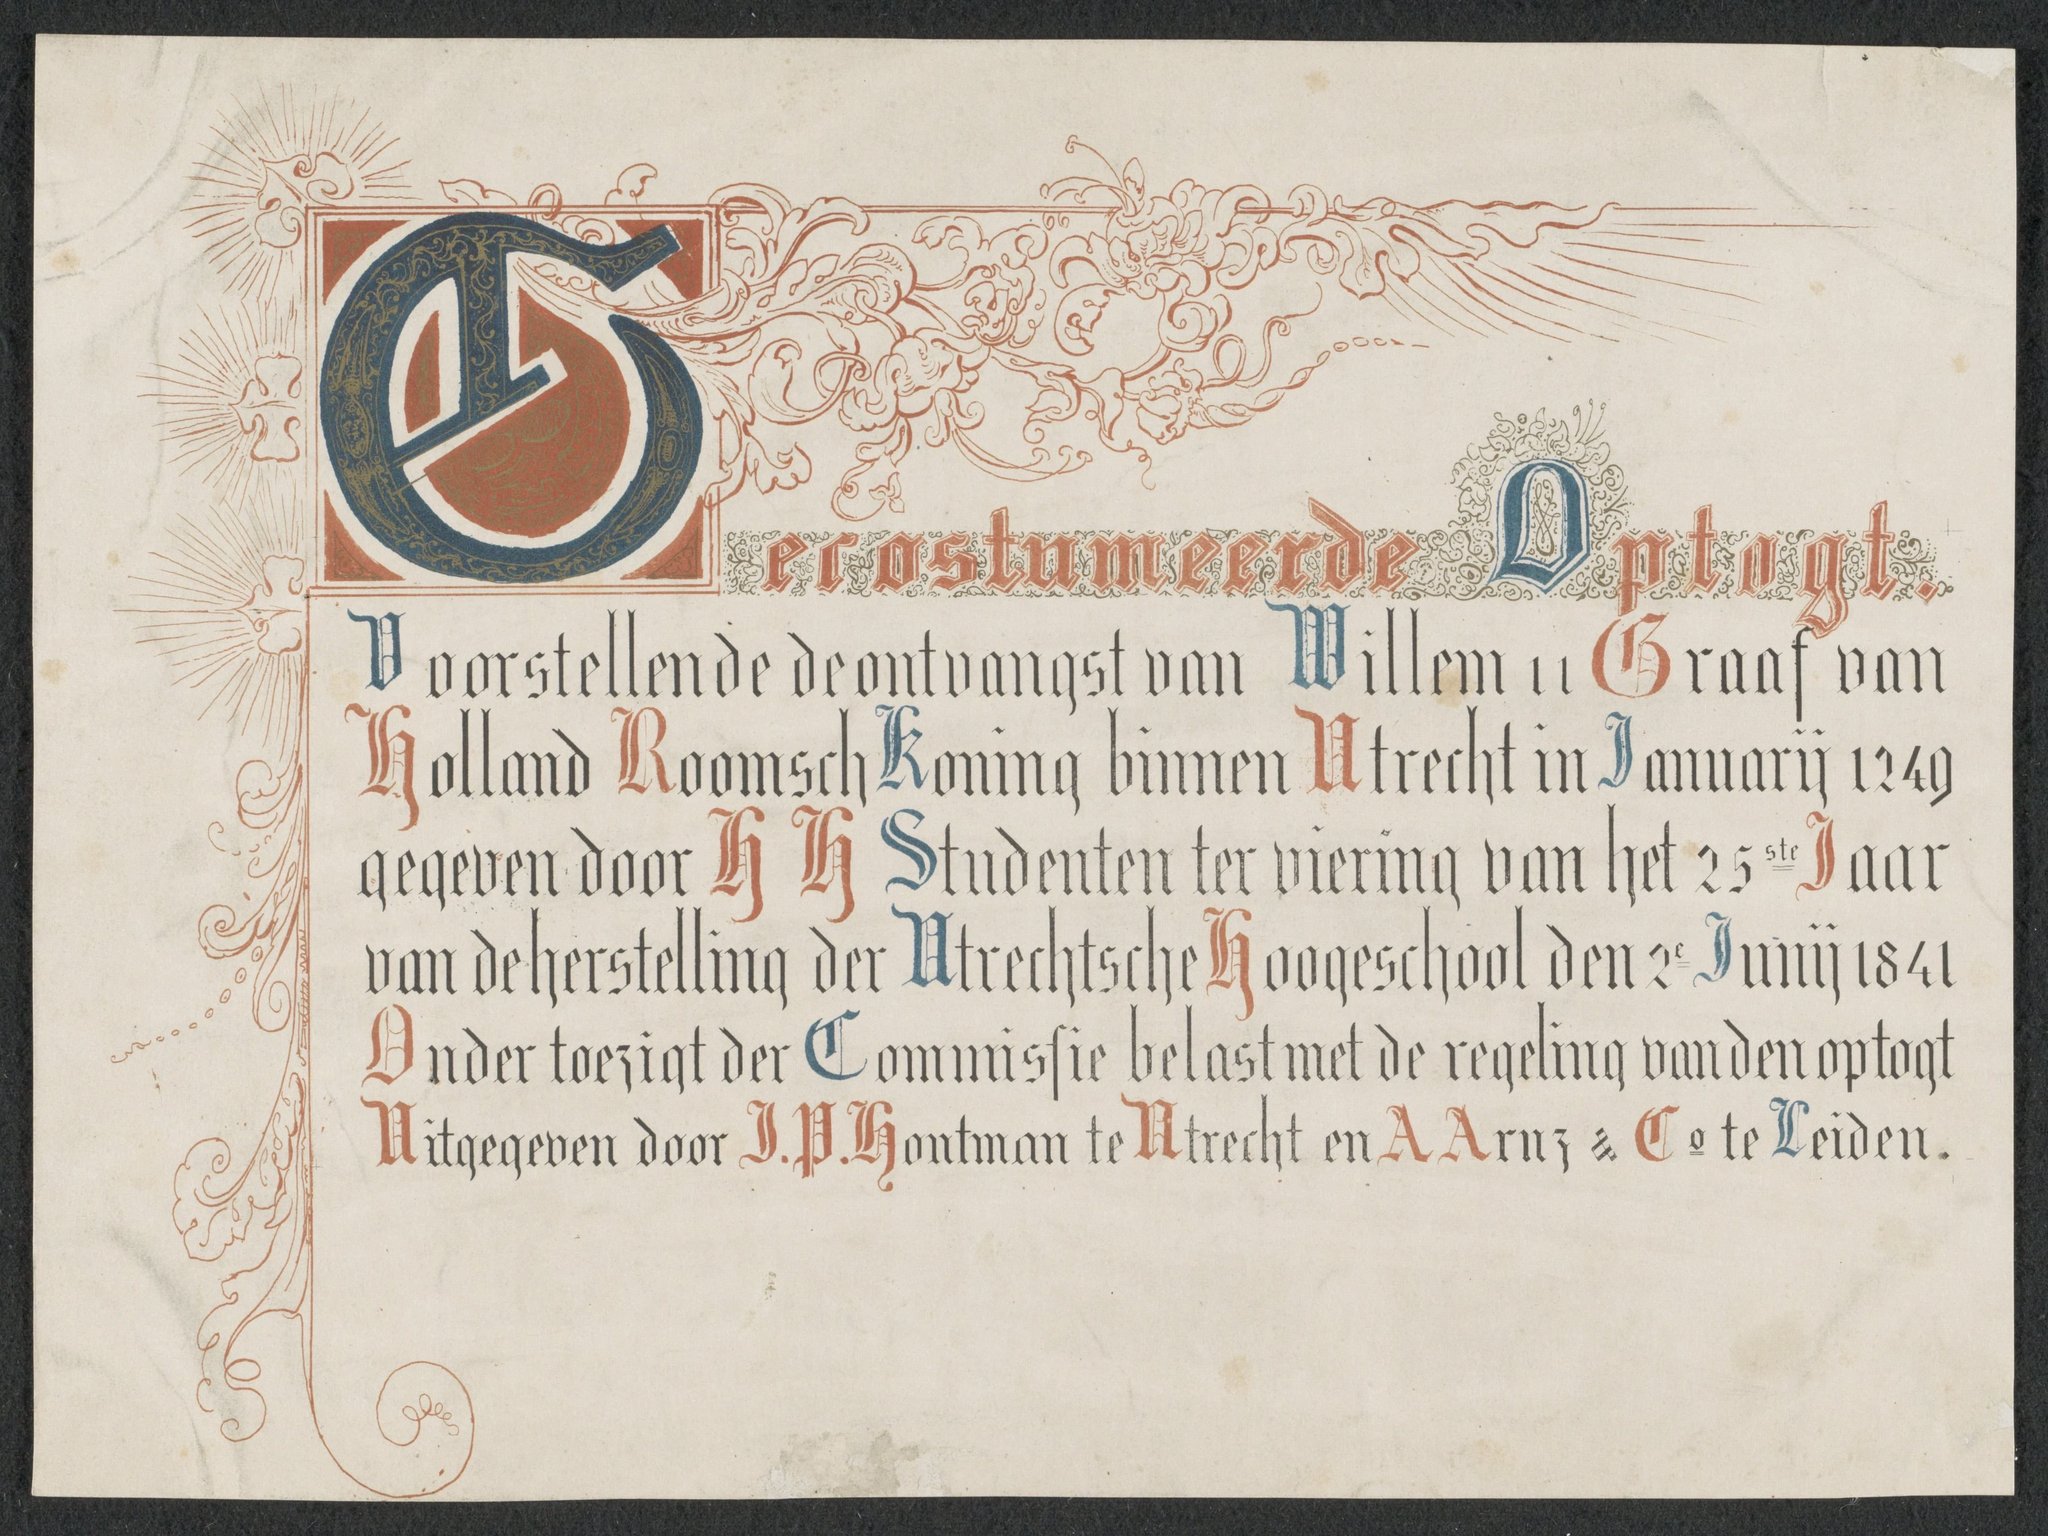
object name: print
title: Gecostumeerde Optogt. Voorstellende de ontvangst van Willem II Graaf van Holland Roomsch Koning binnen Utrecht in Januarij 1249 gegeven door HH Studenten ter viering van het 25ste Jaar van de Herstelling der Utrechtsche Hoogeschool den 2e Junij 1841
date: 1841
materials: paper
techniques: lithograph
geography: utrecht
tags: earl, students' pageant, costumes used in pageants, utrecht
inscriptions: collector's mark: Lugt 2228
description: Titelblad bij een serie van achttien platen van de historische gekostumeerde optocht voorstellende de ontvangst van graaf Willem II van Holland in Utrecht in 1249. De optocht gehouden door de studenten van de Universiteit van Utrecht op 2 juni 1841 ter gelegenheid van de viering van het vijfentwintigjarige herstel van de Hogeschool. Tekst met versierde initiaal.